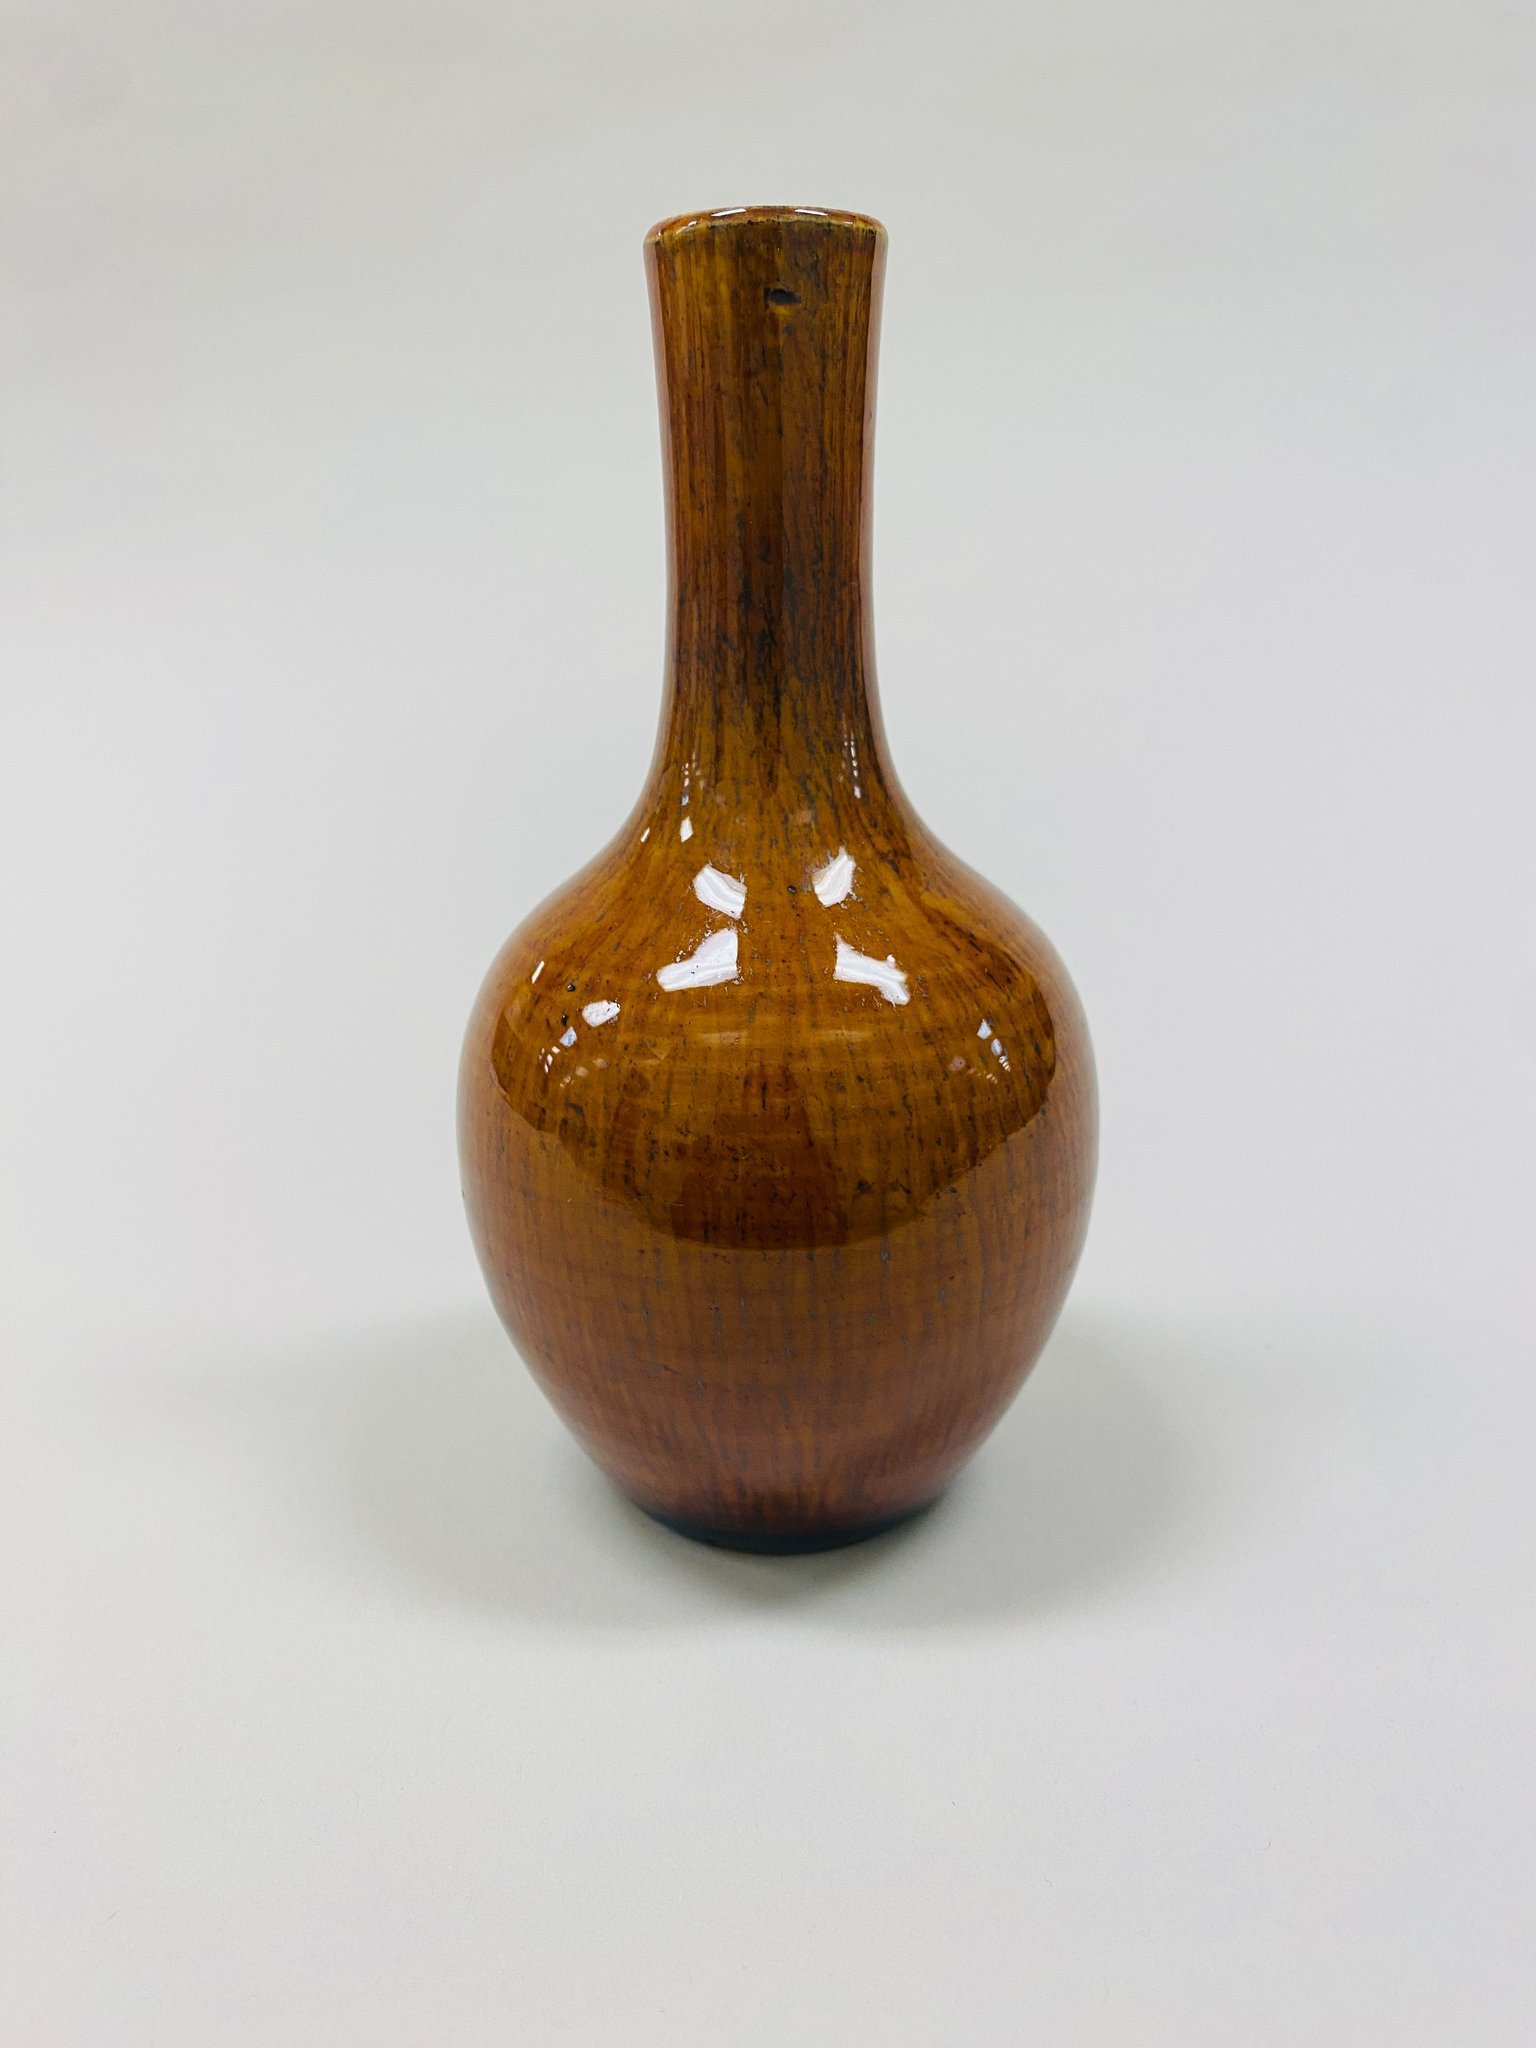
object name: vase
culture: chinese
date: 1701-1800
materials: glaze, porcelain